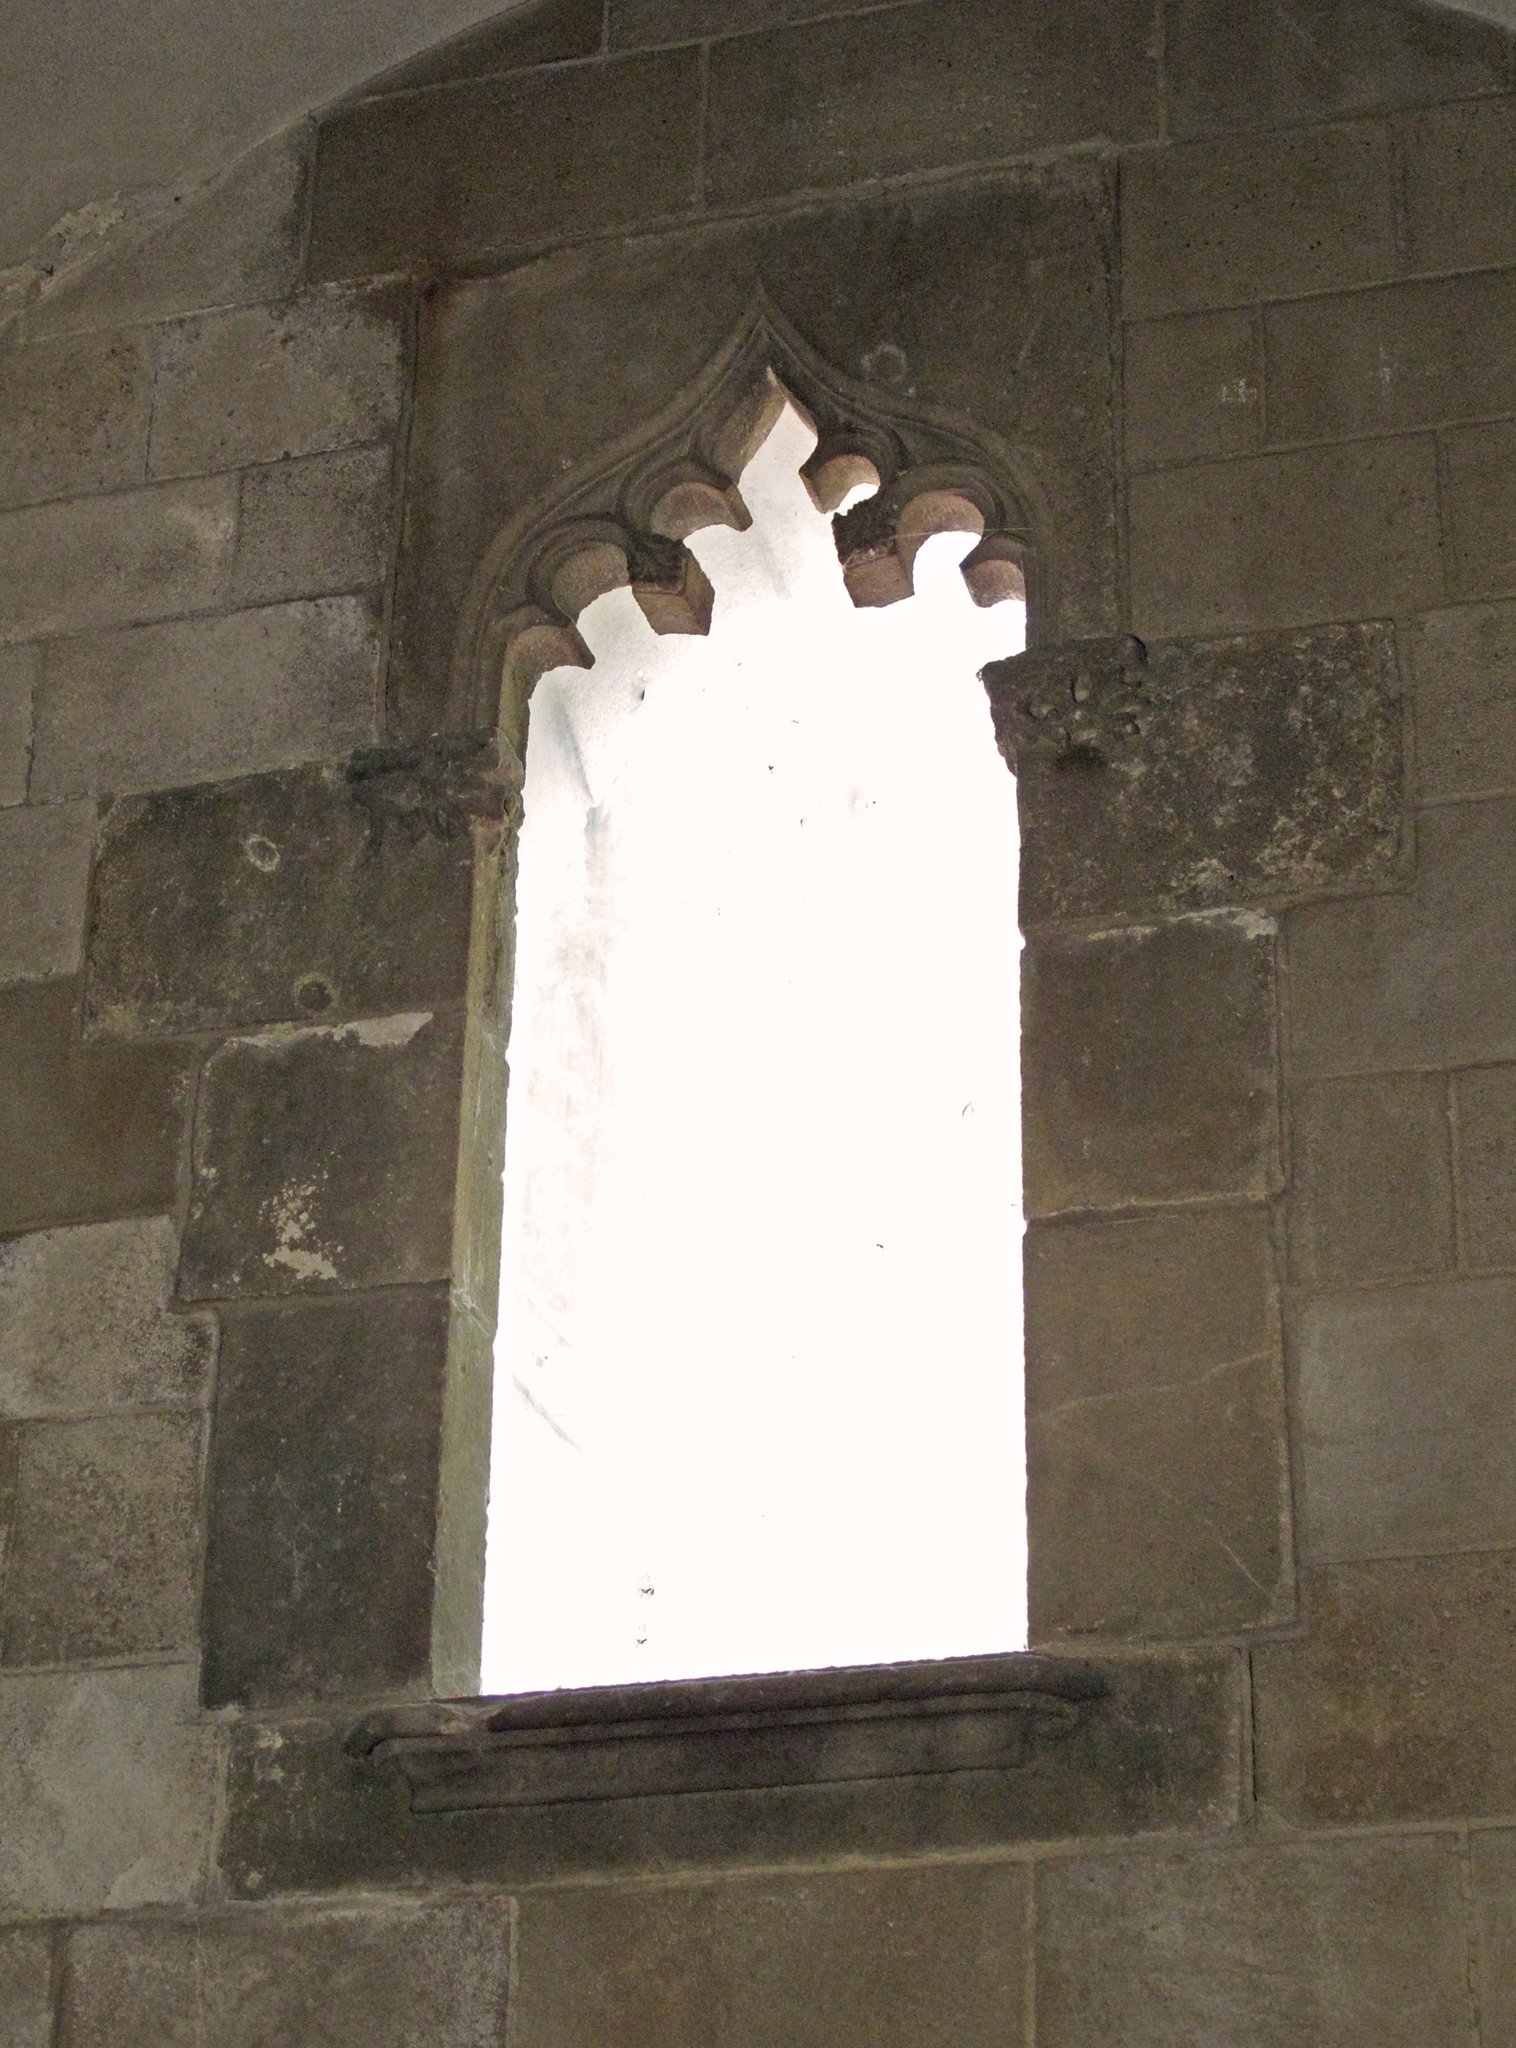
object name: window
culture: french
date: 1401-1500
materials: limestone